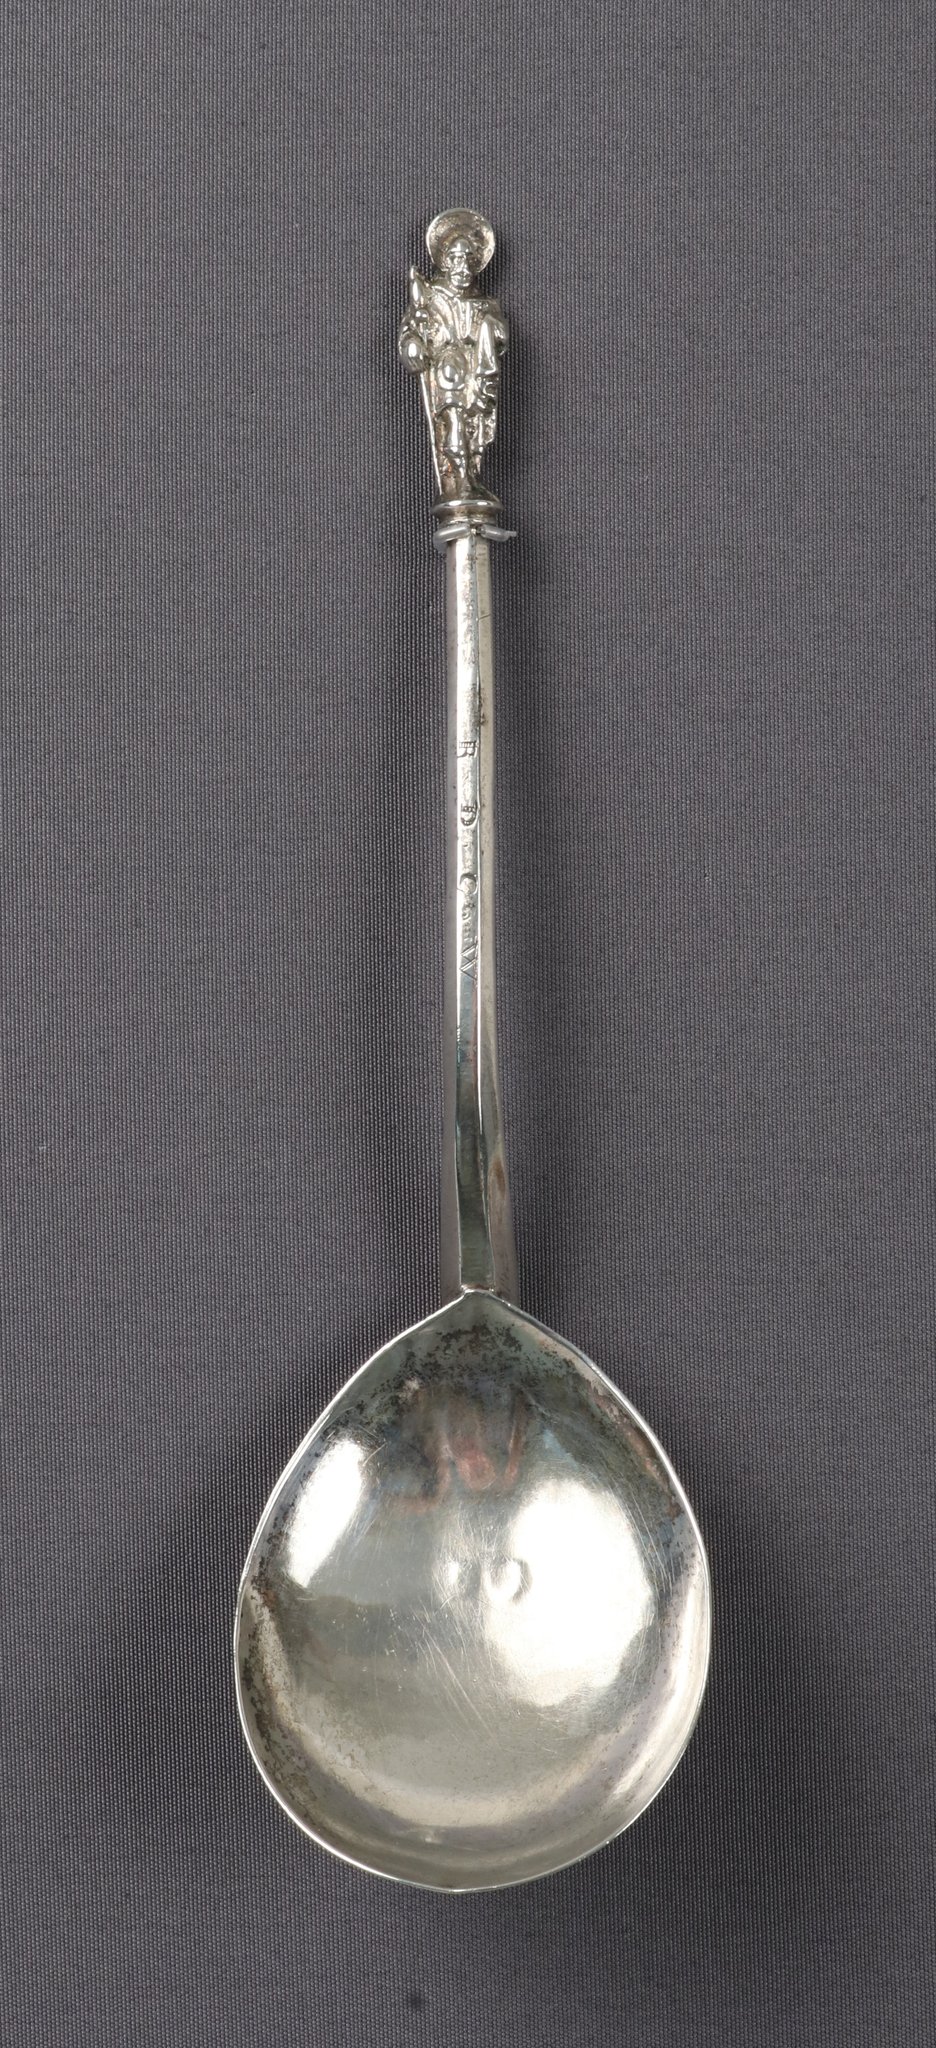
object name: apostle spoon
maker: johannes i weber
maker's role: maker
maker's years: 1580-1680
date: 1670-1680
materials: silver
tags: apostles